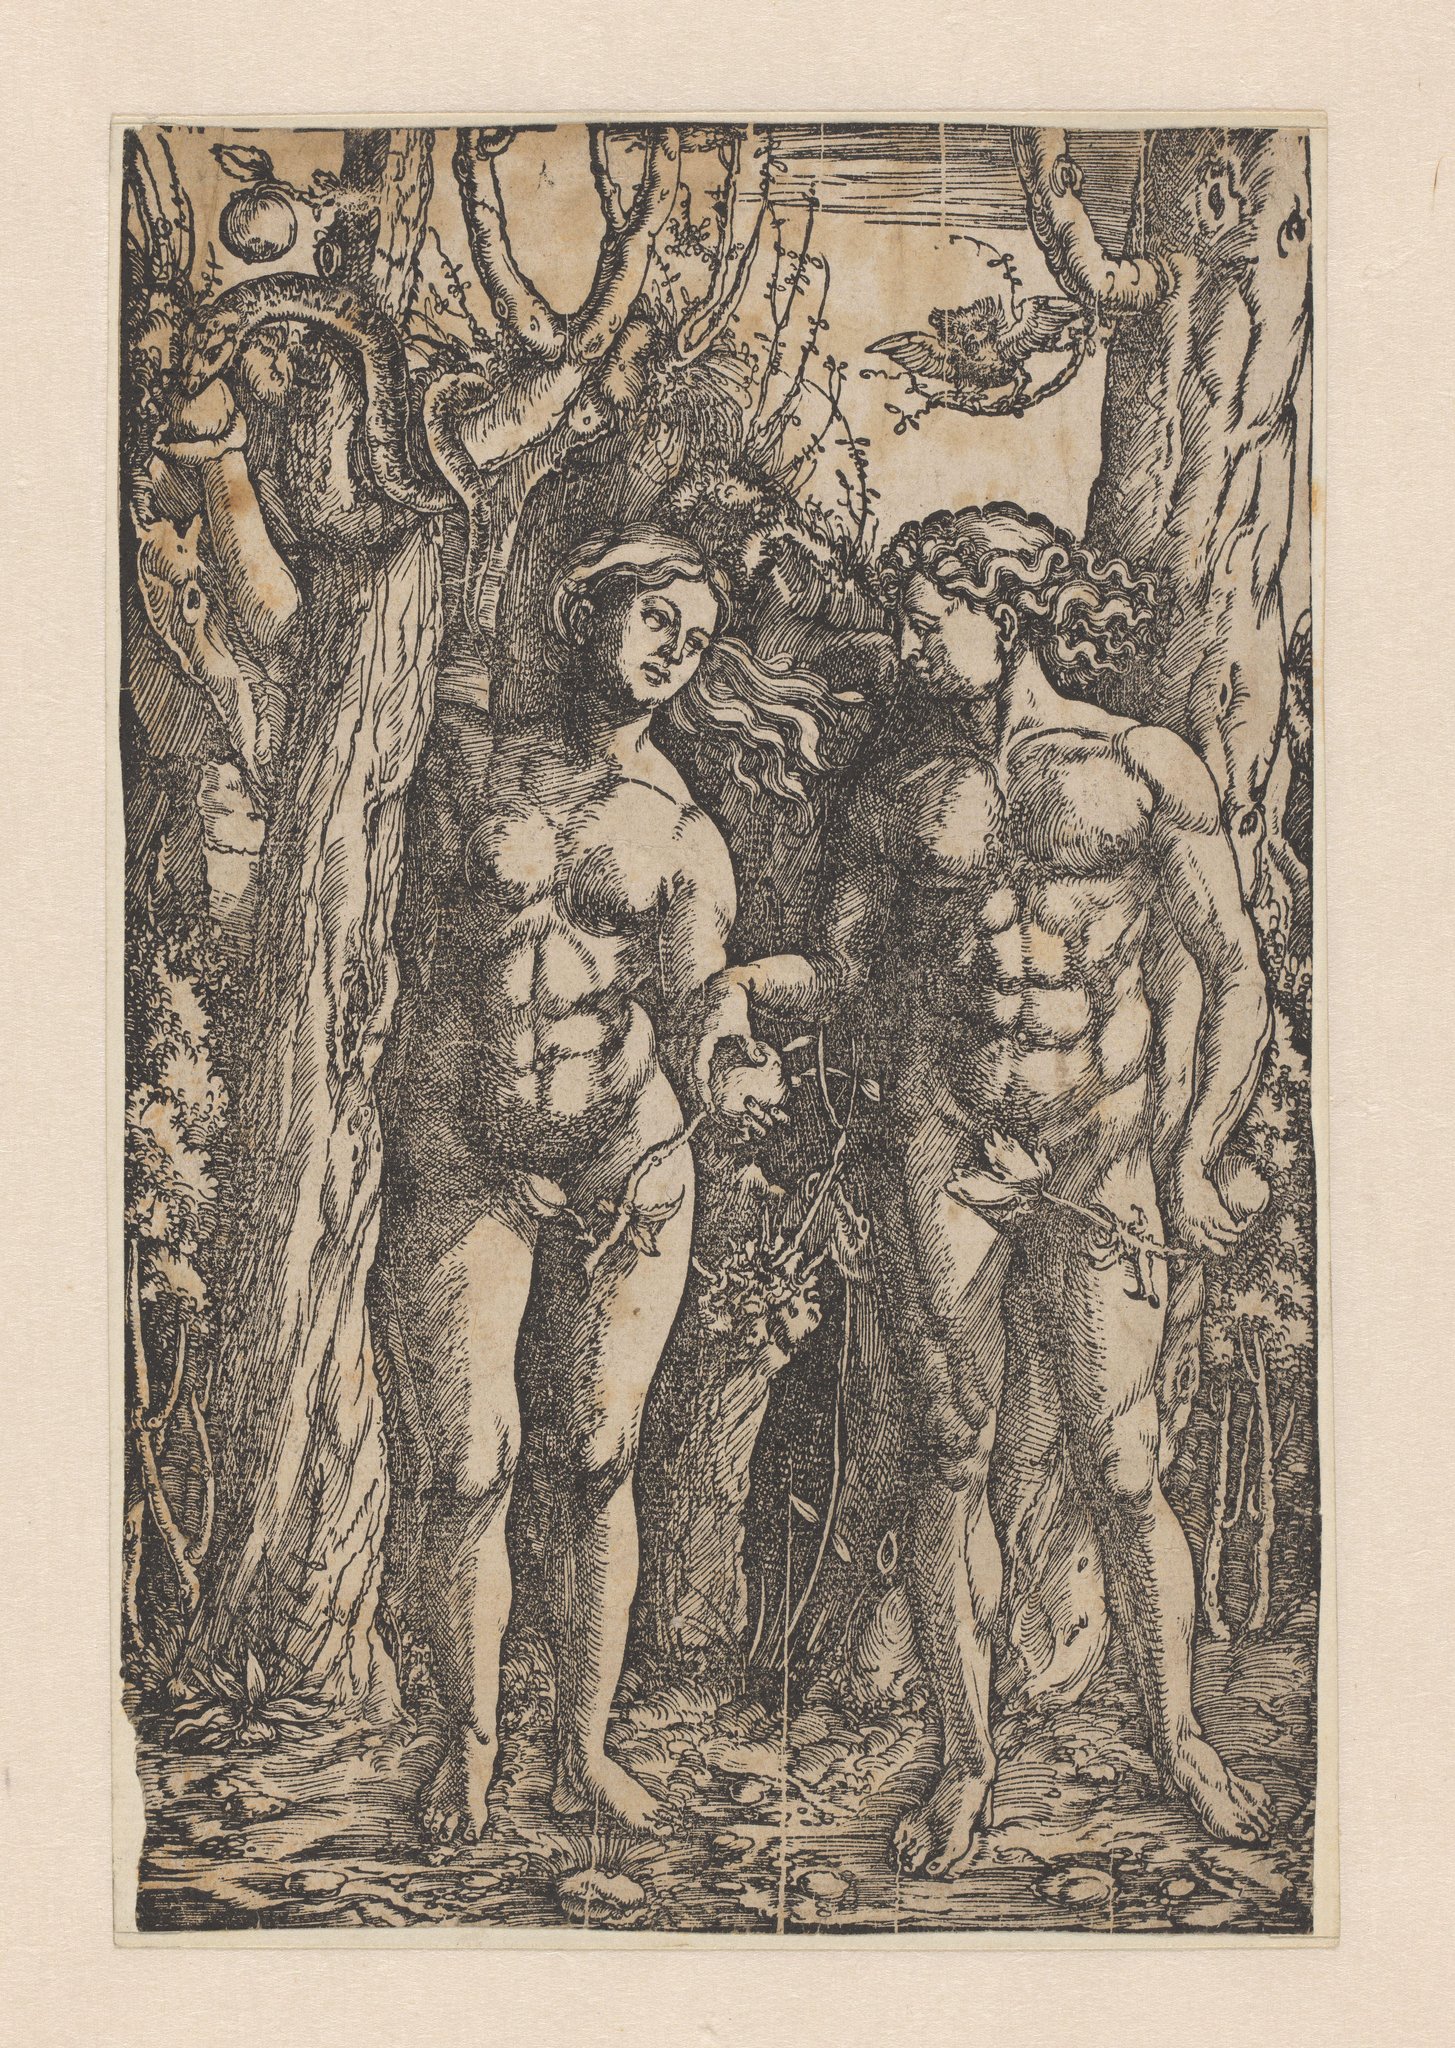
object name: print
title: De zondeval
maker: hans springinklee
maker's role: print maker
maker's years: -1540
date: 1500-1550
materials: paper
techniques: woodcut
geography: germany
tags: eve simultaneously offers some of the fruit to adam and takes some more from the serpent (or the tree)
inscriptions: collector's mark: Lugt 2228